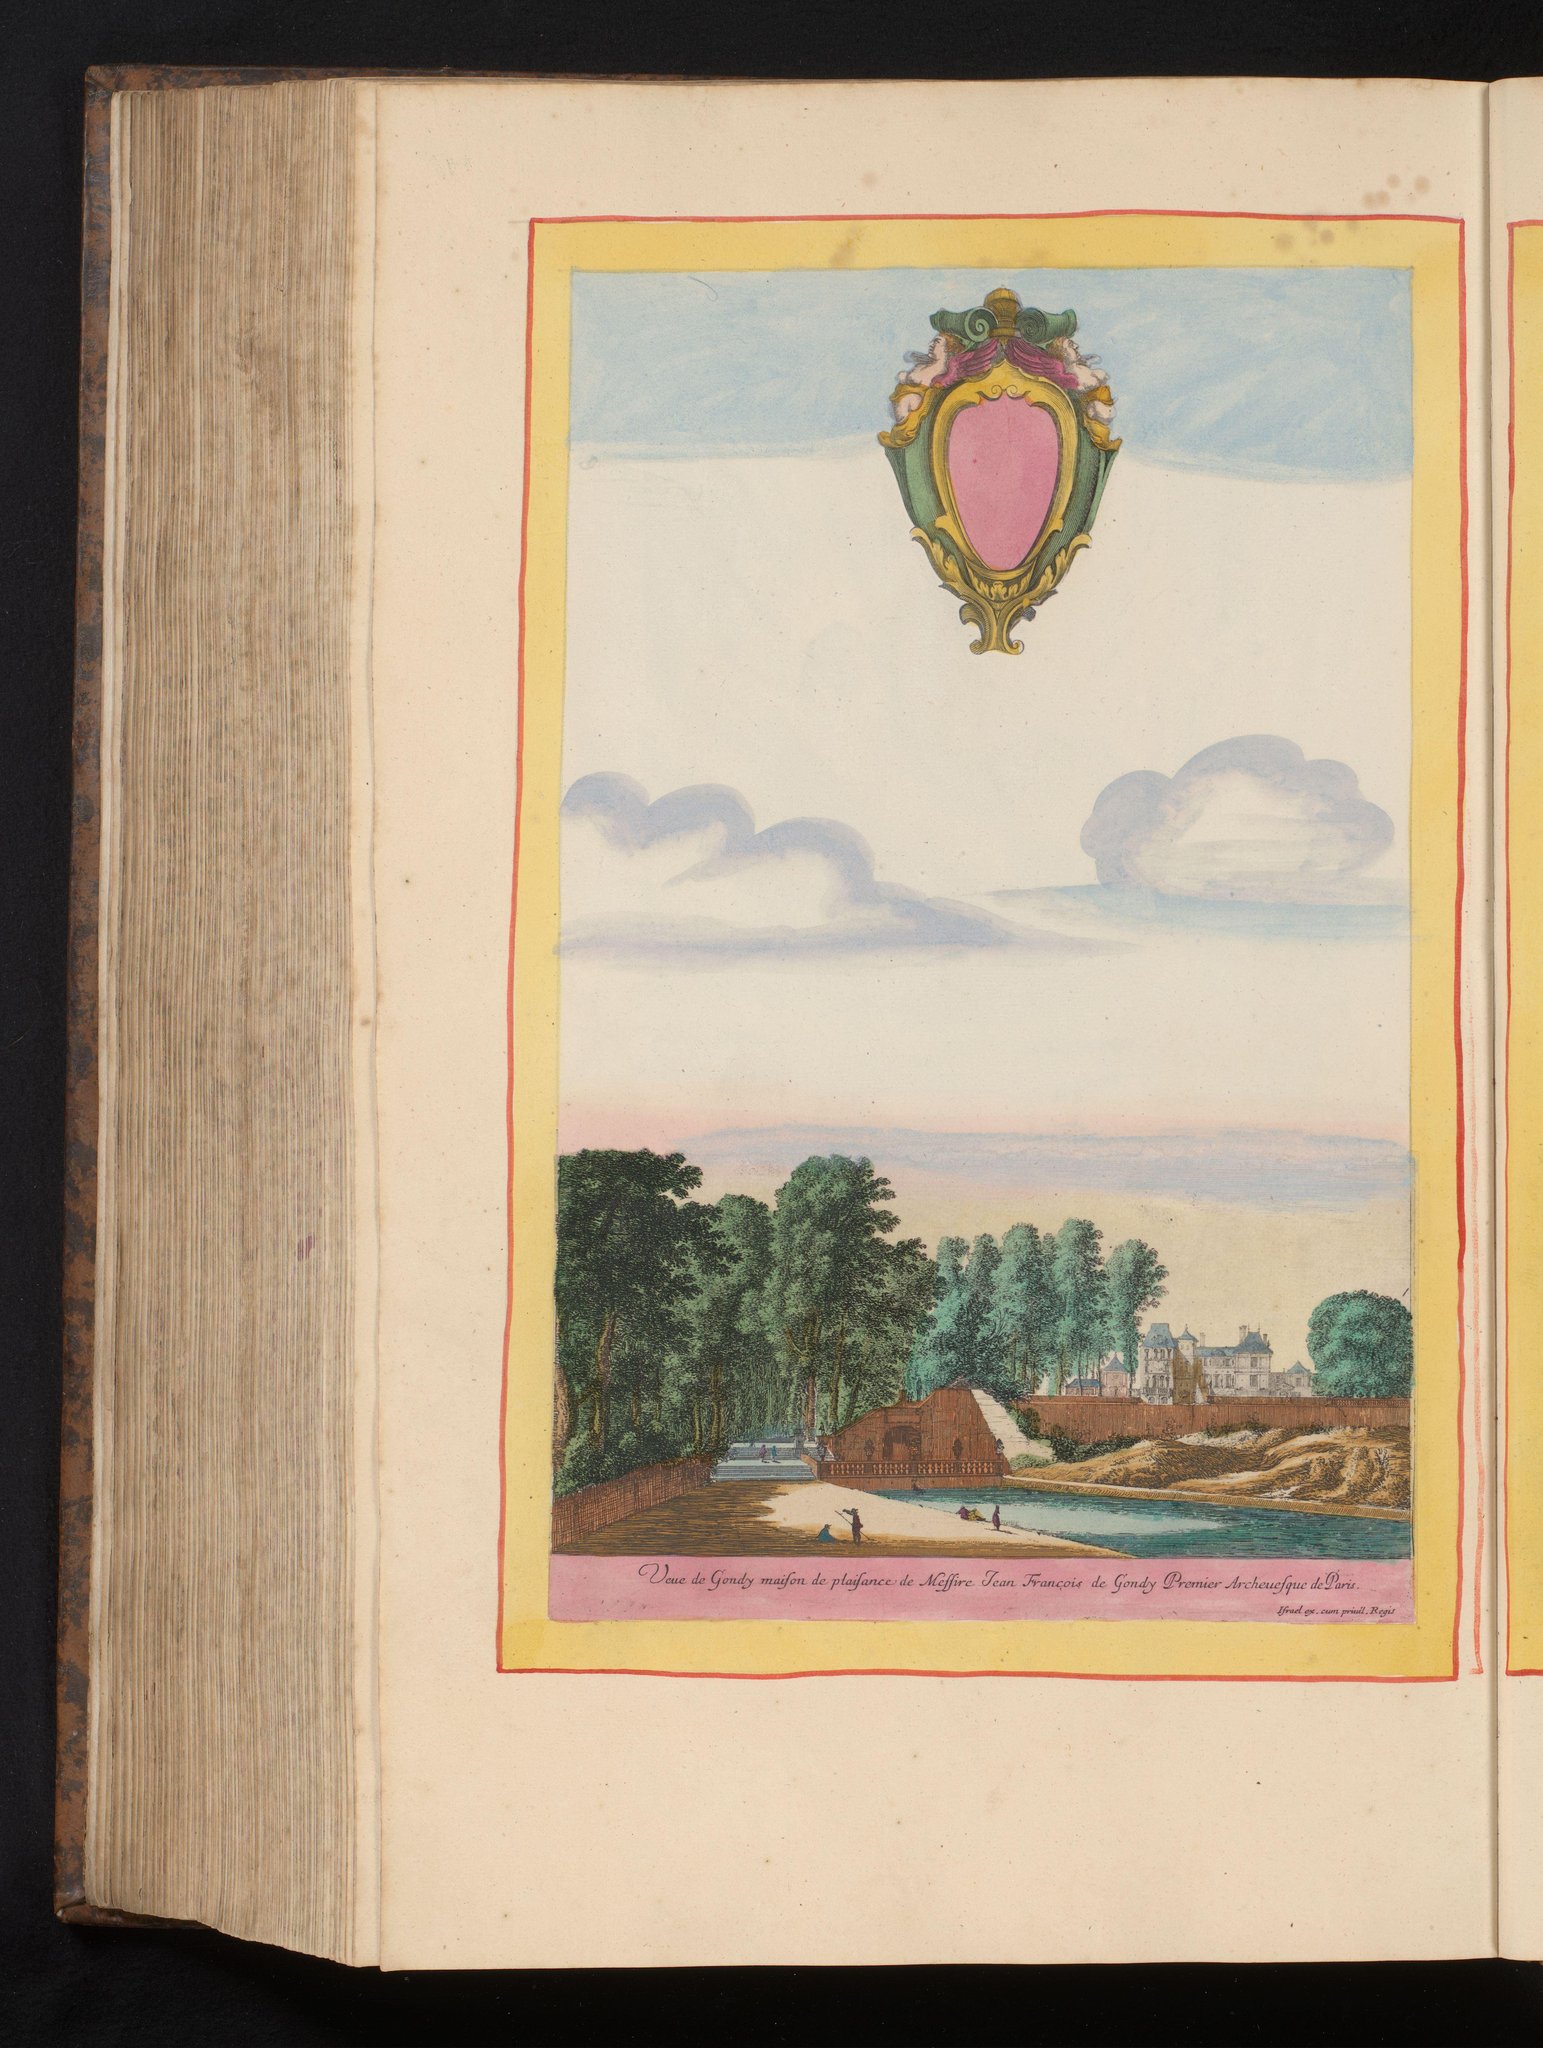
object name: album leaf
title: Veue de Gondy maison de plaisance de Messire Jean Francois de Gondy Premier Archevesque de Paris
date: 1631-1661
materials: paper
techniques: etching, hand coloring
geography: paris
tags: castle, garden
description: Gezicht op Château de Saint-Cloud, huis van Jean-François de Gondi eerste aartsbisschop van Parijs. In de lucht een ornamenteel leeg wapenschild. Prent maakt deel uit van een album.